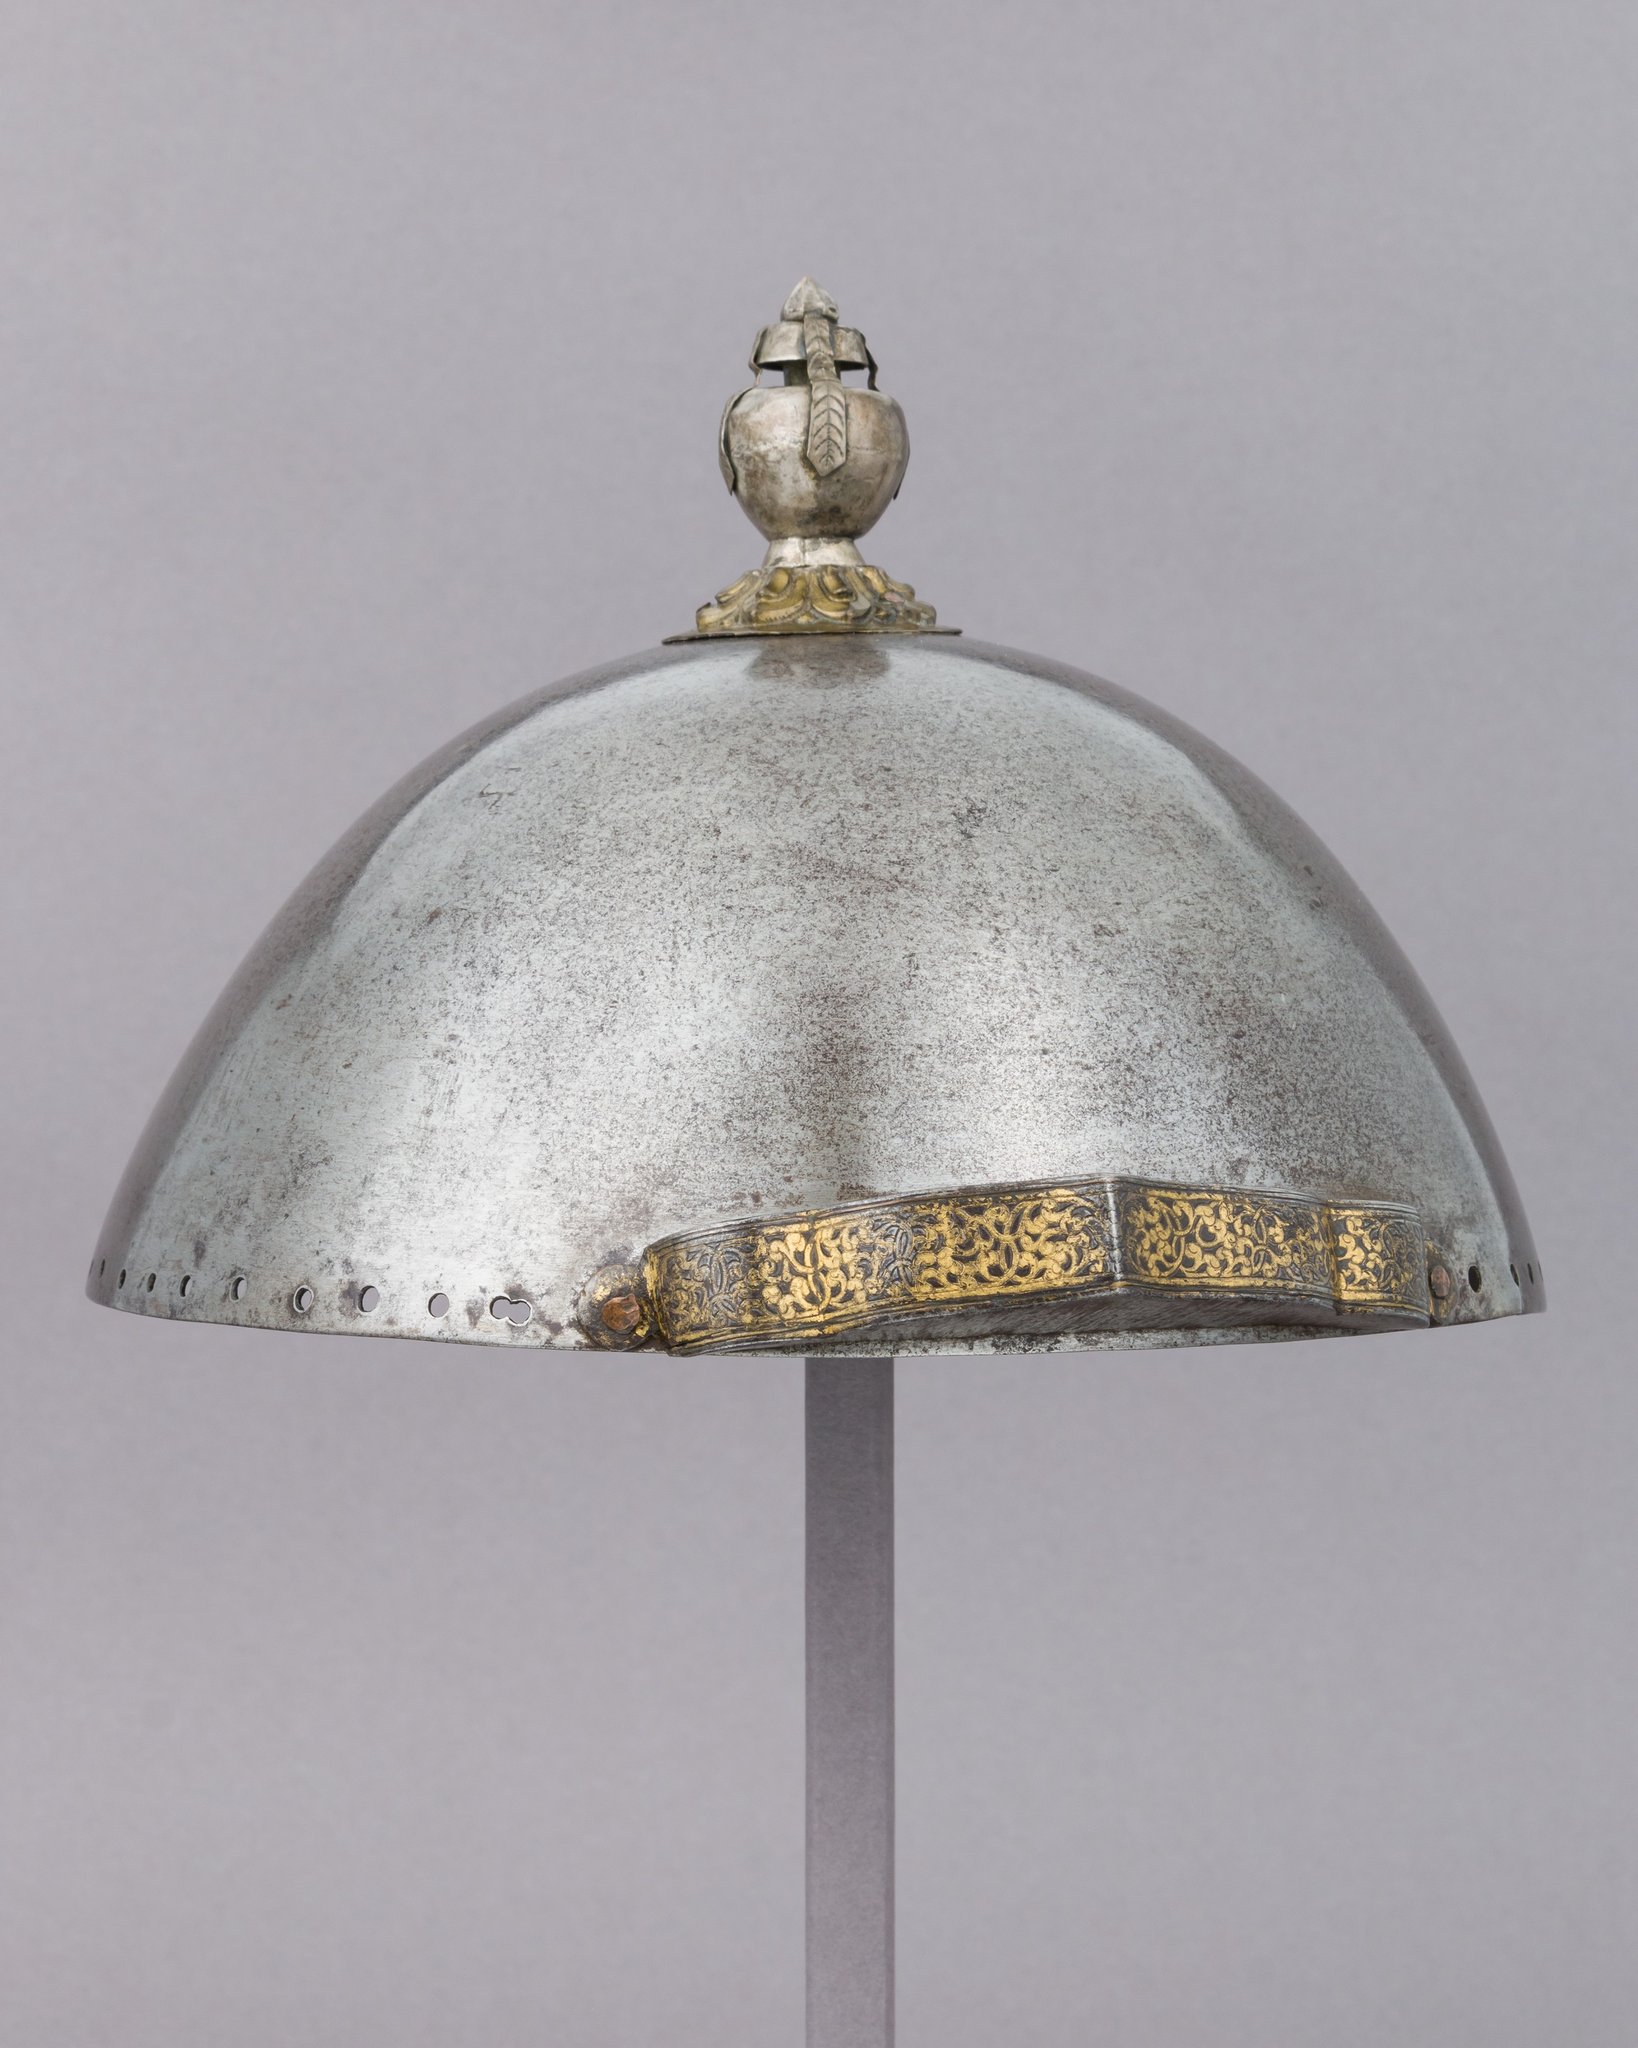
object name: helmet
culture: bhutanese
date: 1701-1900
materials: brass, gold, silver, steel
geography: bhutan